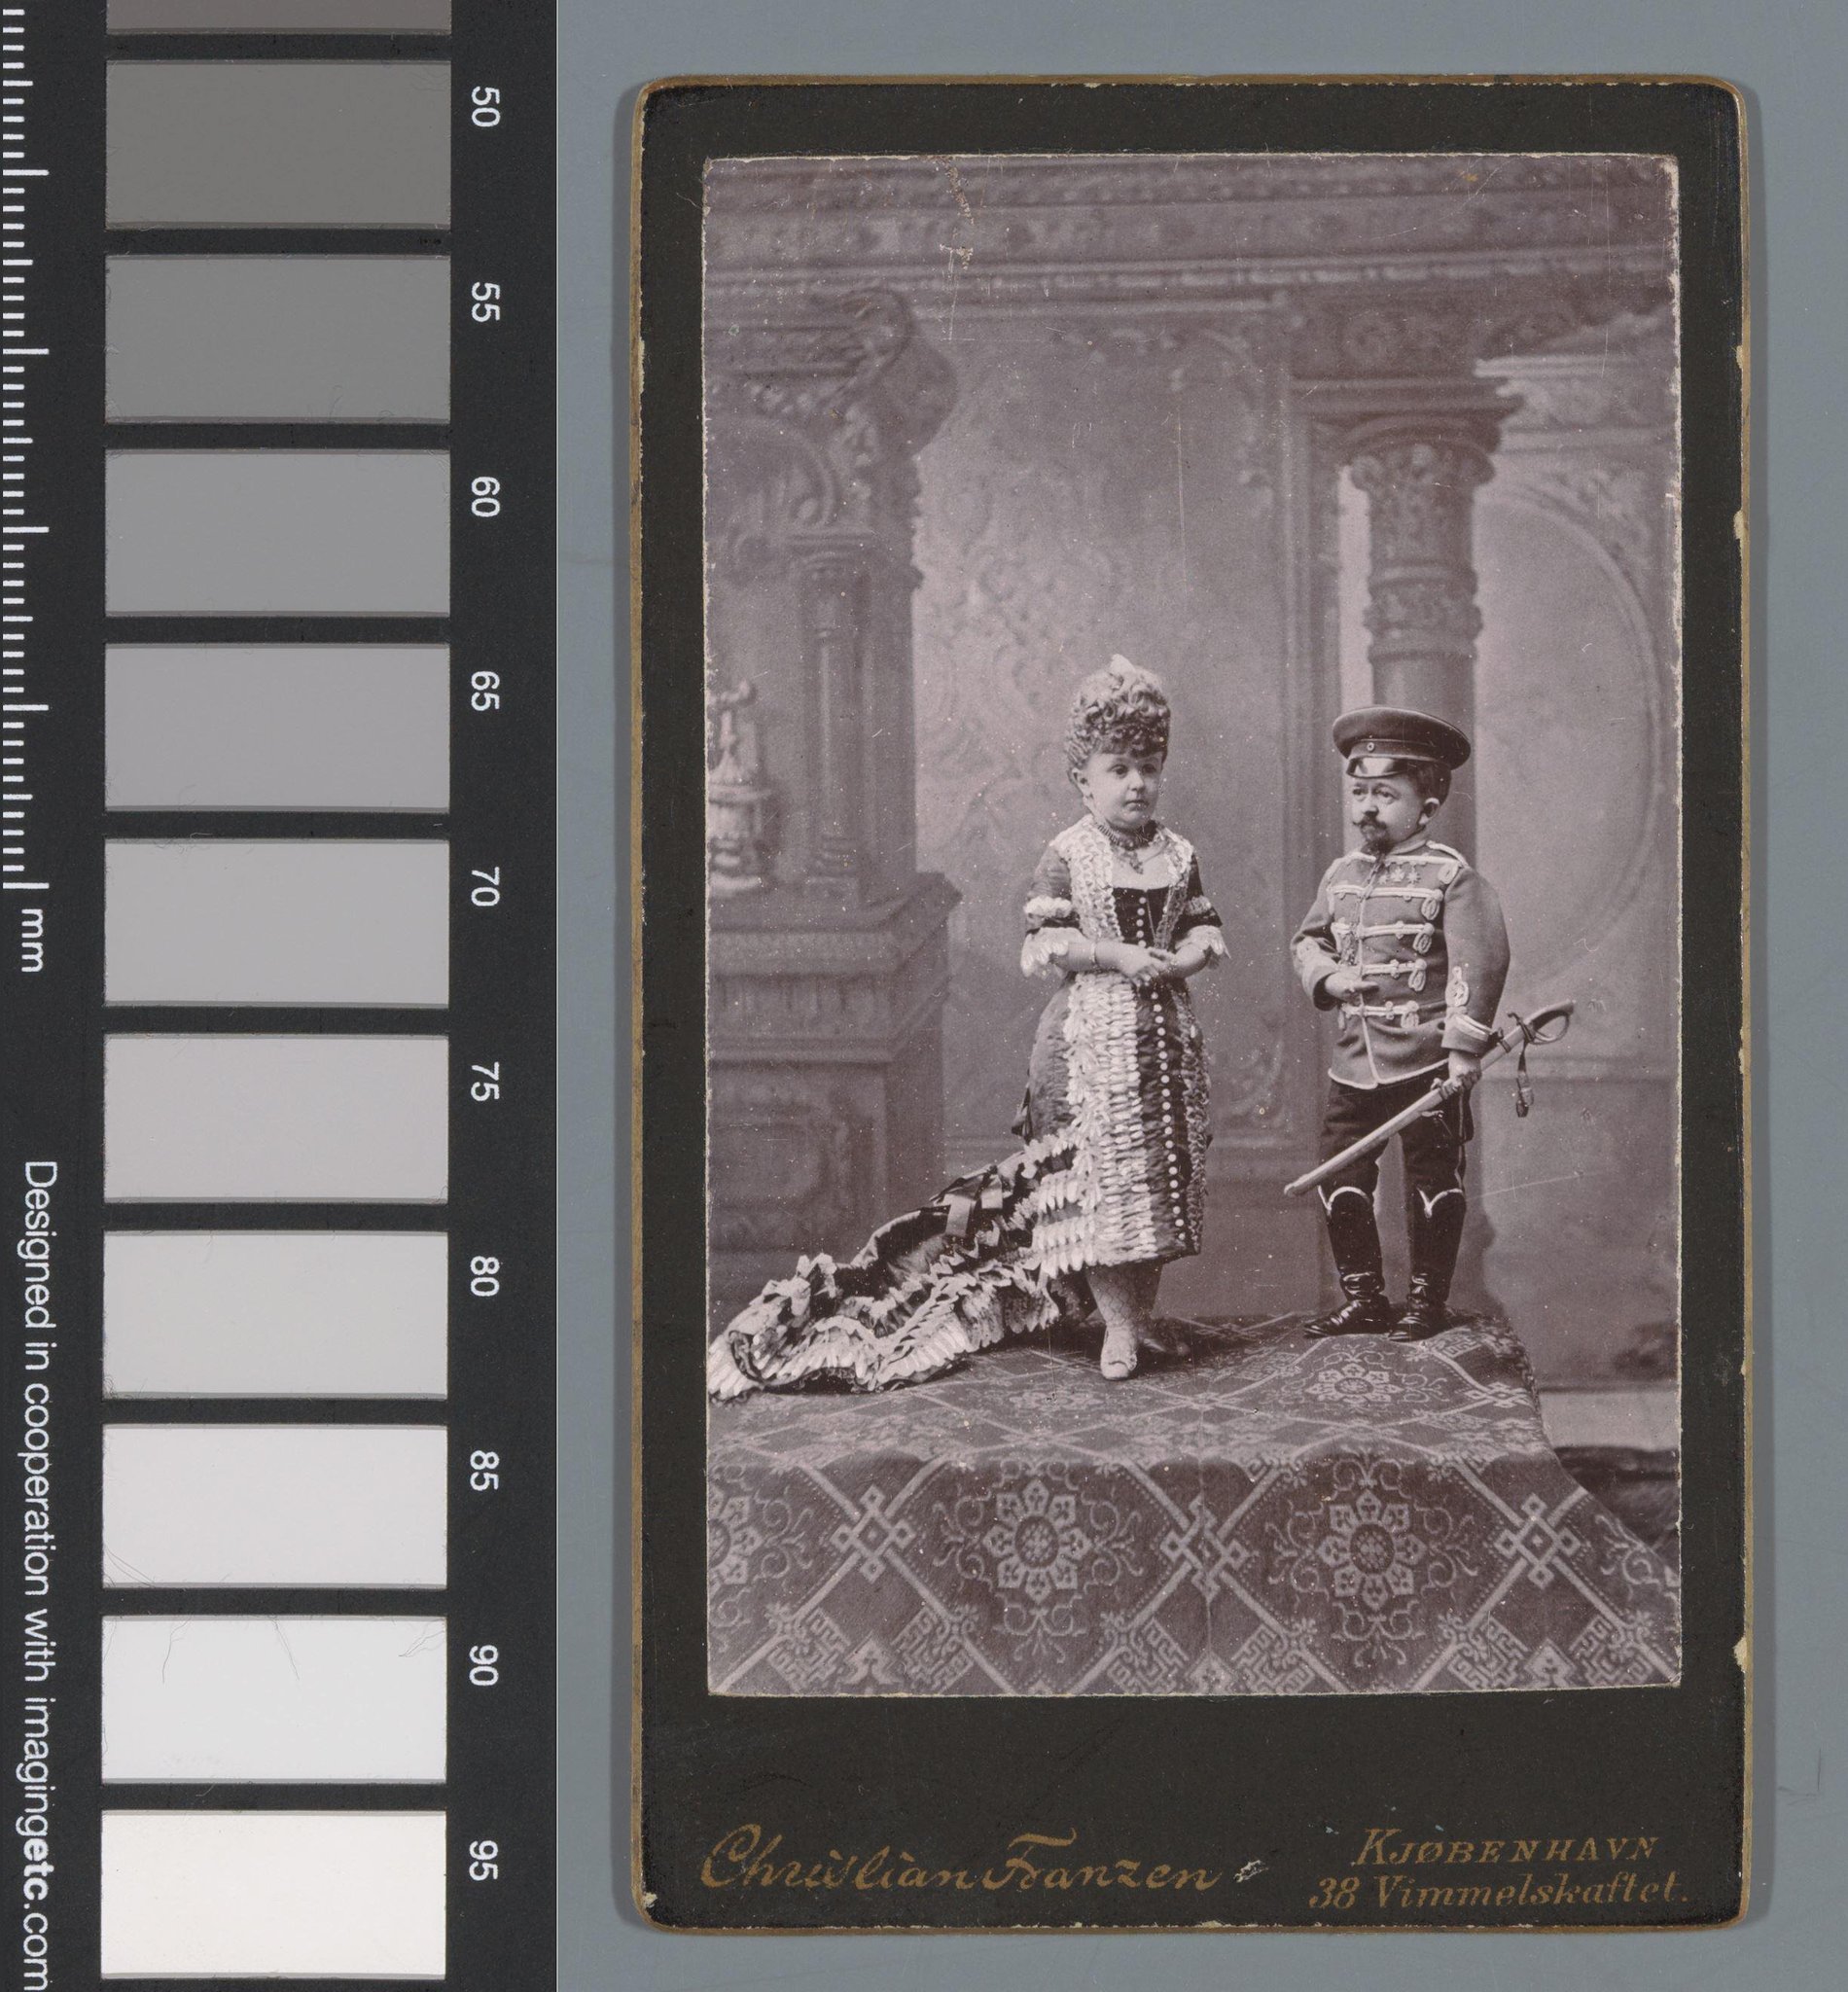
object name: carte de visite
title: Portret van een onbekende kleine man en een onbekende kleine vrouw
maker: christian franzen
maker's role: fotograaf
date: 1850-1900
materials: cardboard, photographic support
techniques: collodion silver print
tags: adult woman, adult man, historical persons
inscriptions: address: ‘Christian Franzen KJØBENHAVN/ 38 Vimmelskaftet.’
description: Portret van een onbekende man en een onbekende vrouw (kleine mensen).